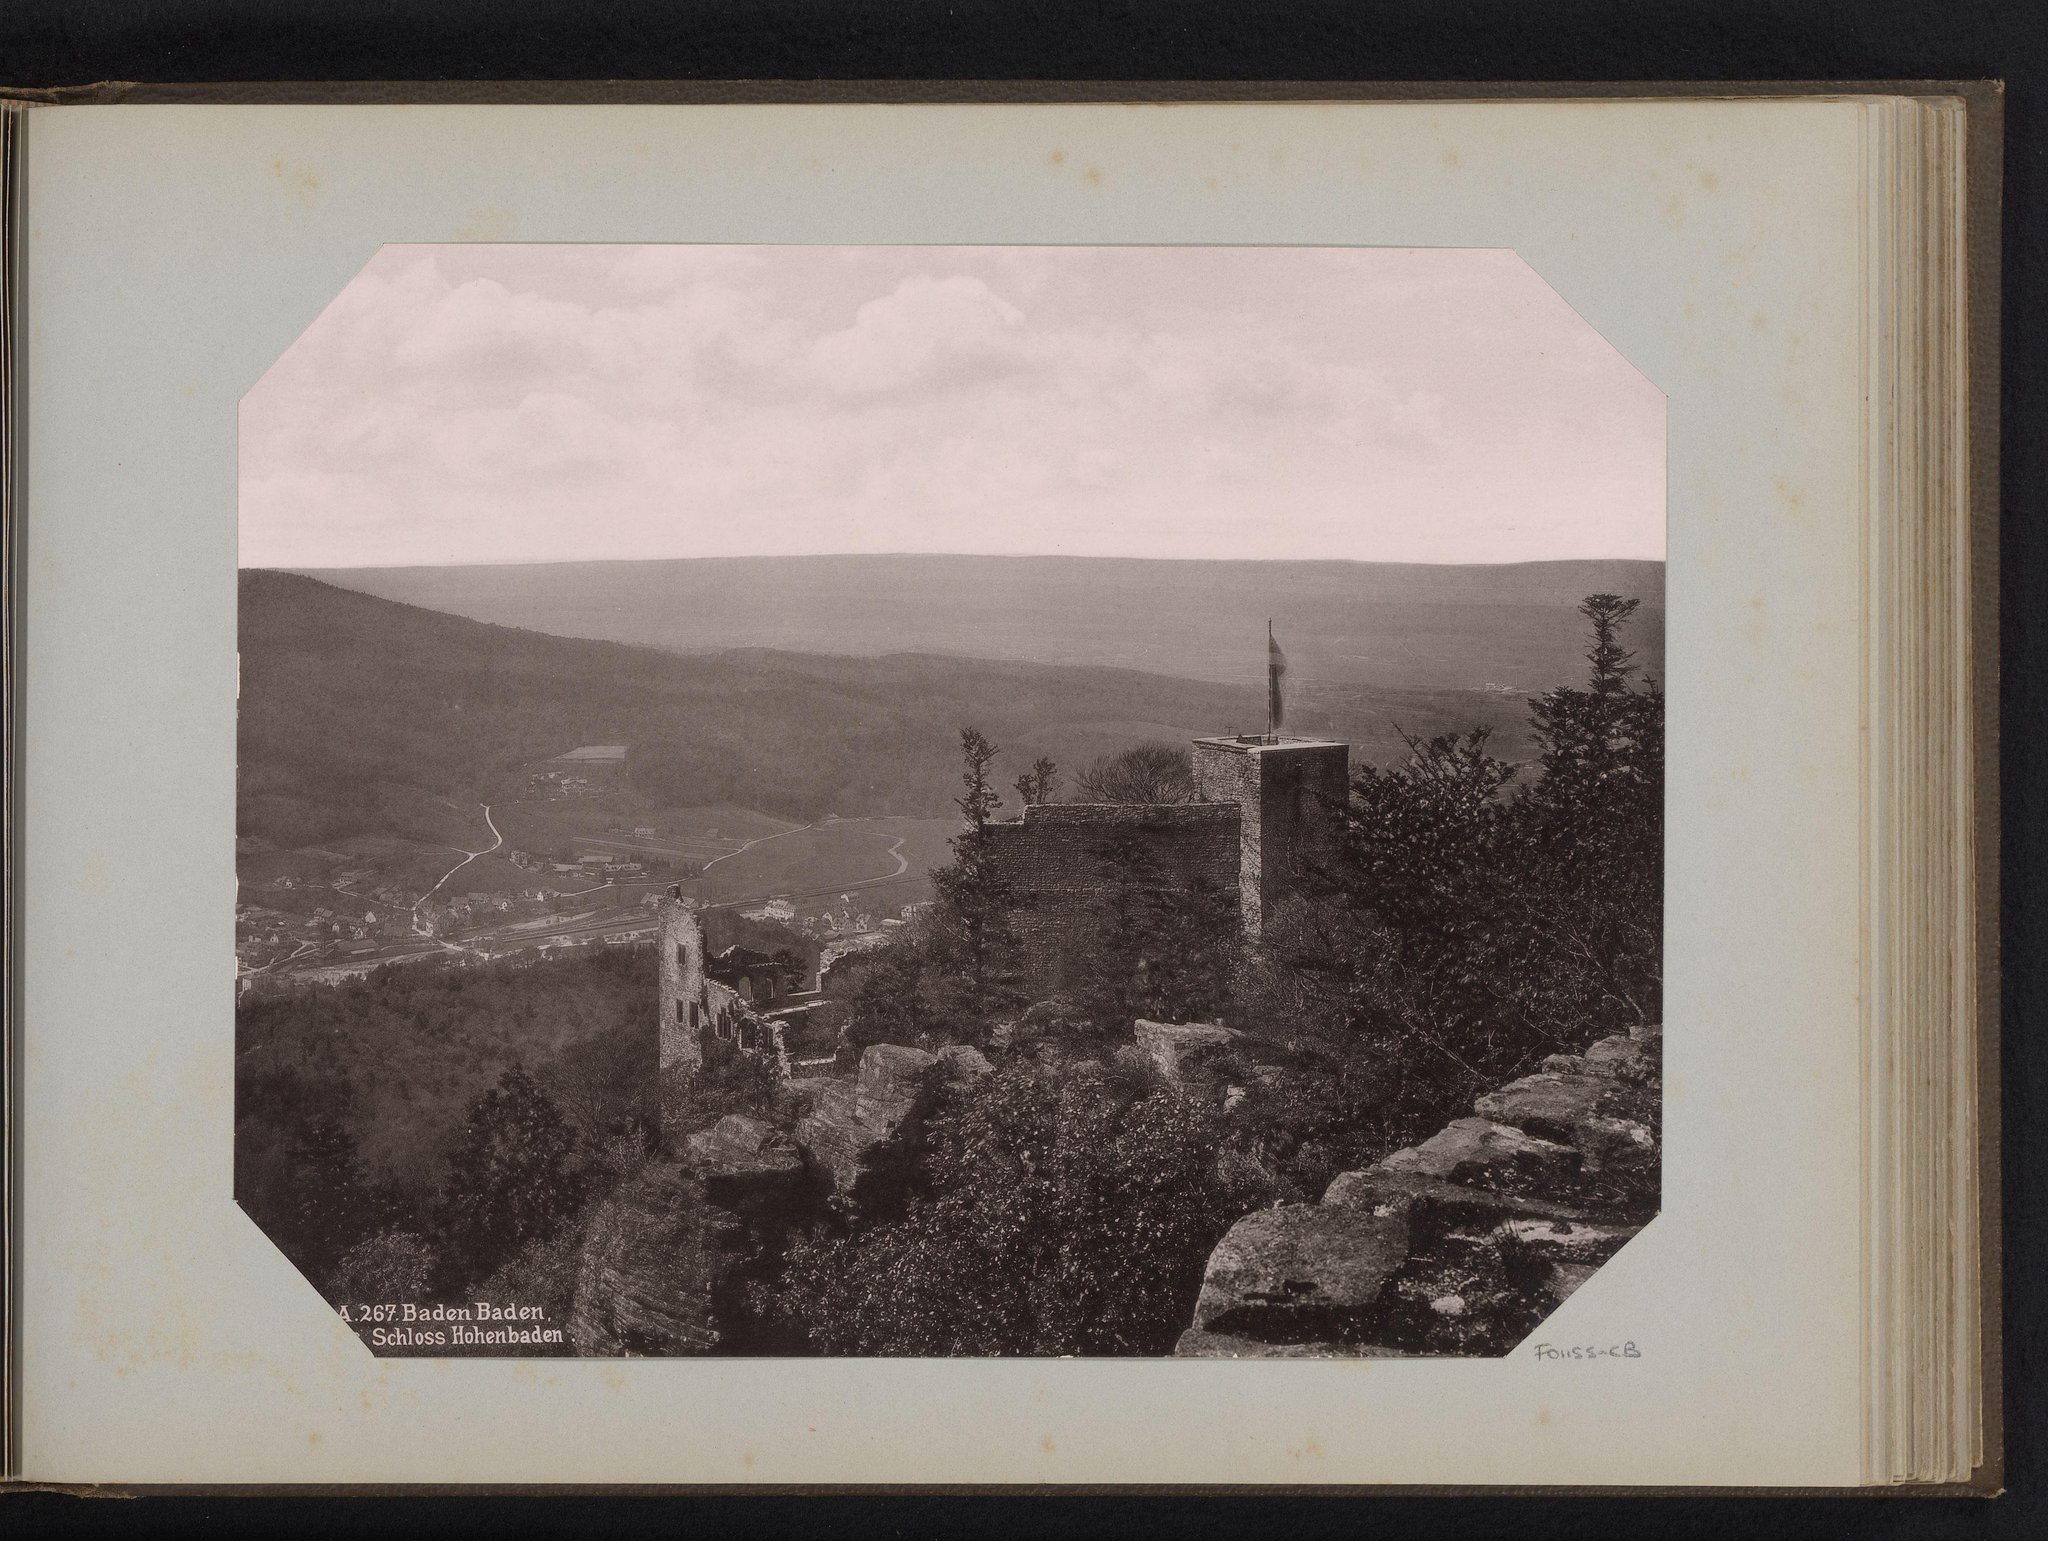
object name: album leaf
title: Gezicht op slot Hohenbaden te Baden-Baden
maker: Anonymous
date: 1890-1899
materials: paper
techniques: photograph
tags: landscape with tower or castle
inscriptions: inscription: ‘A. 267. Baden Baden./ Altes Schloss Hohenbaden’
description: Deze prent maakt deel uit van een album.